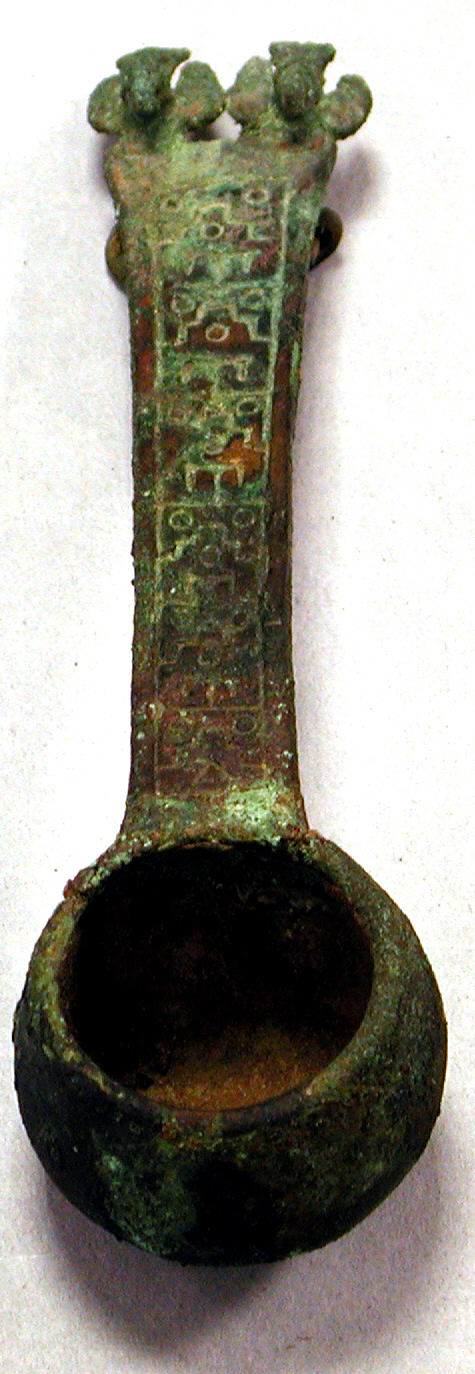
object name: ladle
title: Copper Ladle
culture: chimú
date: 1101-1500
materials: copper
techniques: casting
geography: peru